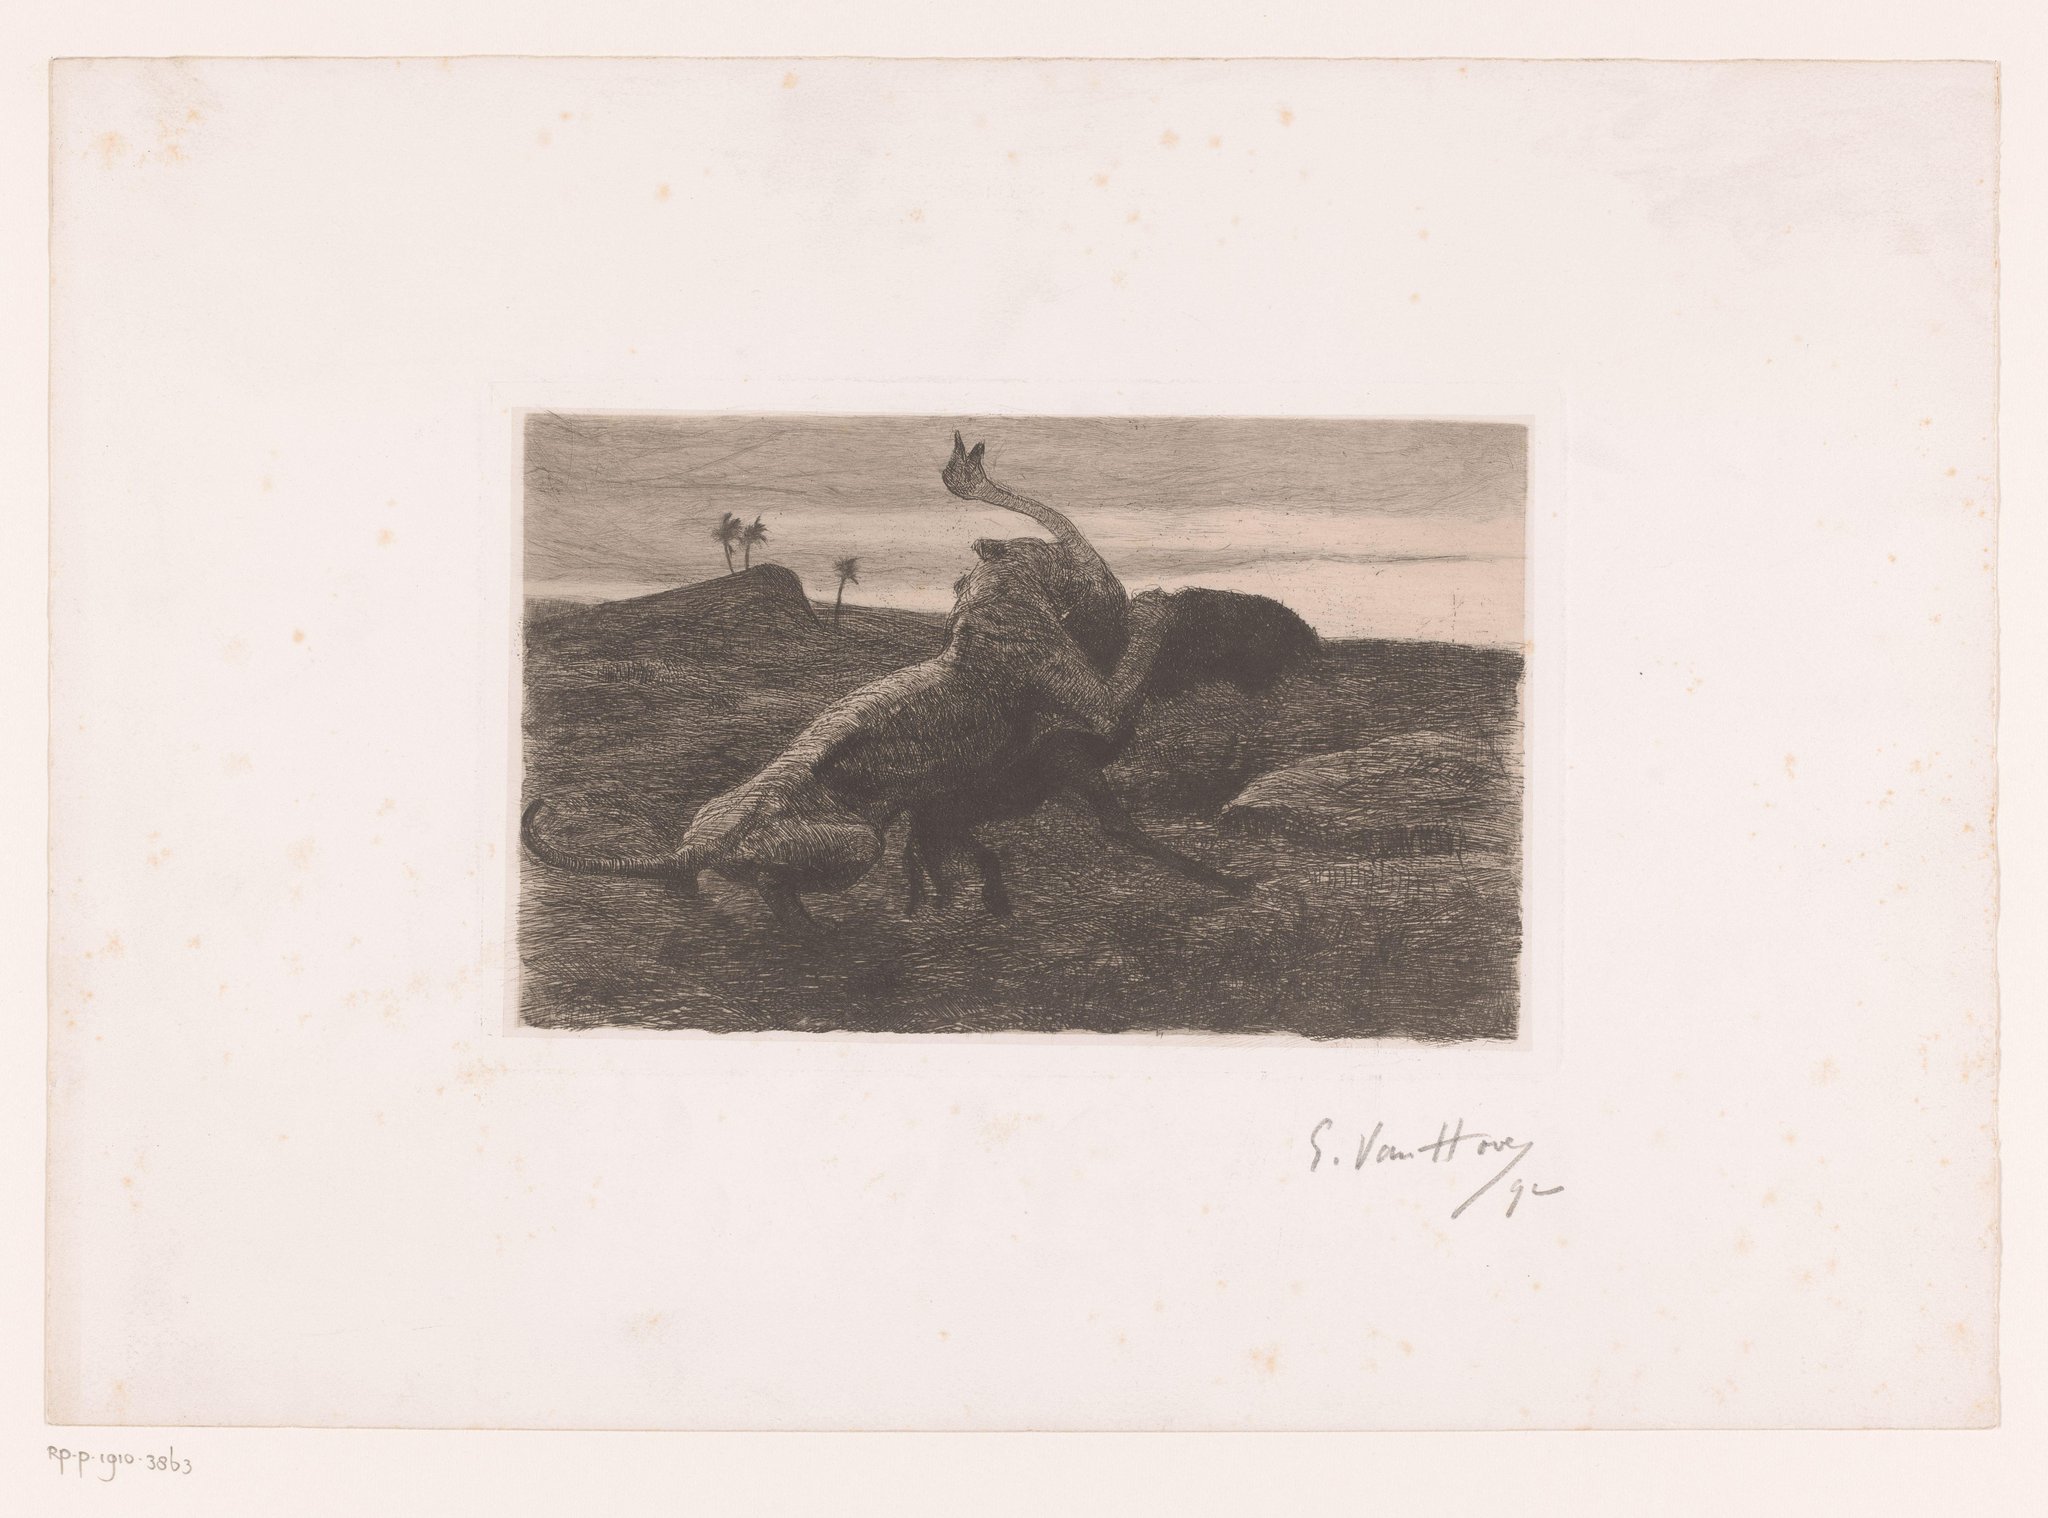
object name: print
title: Gevecht tussen een leeuw en een struisvogel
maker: eugène van hove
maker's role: print maker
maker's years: 1869-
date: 1892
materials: paper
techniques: etching, intaglio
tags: walker and runner birds: ostrich, beasts of prey, predatory animals: lion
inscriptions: date